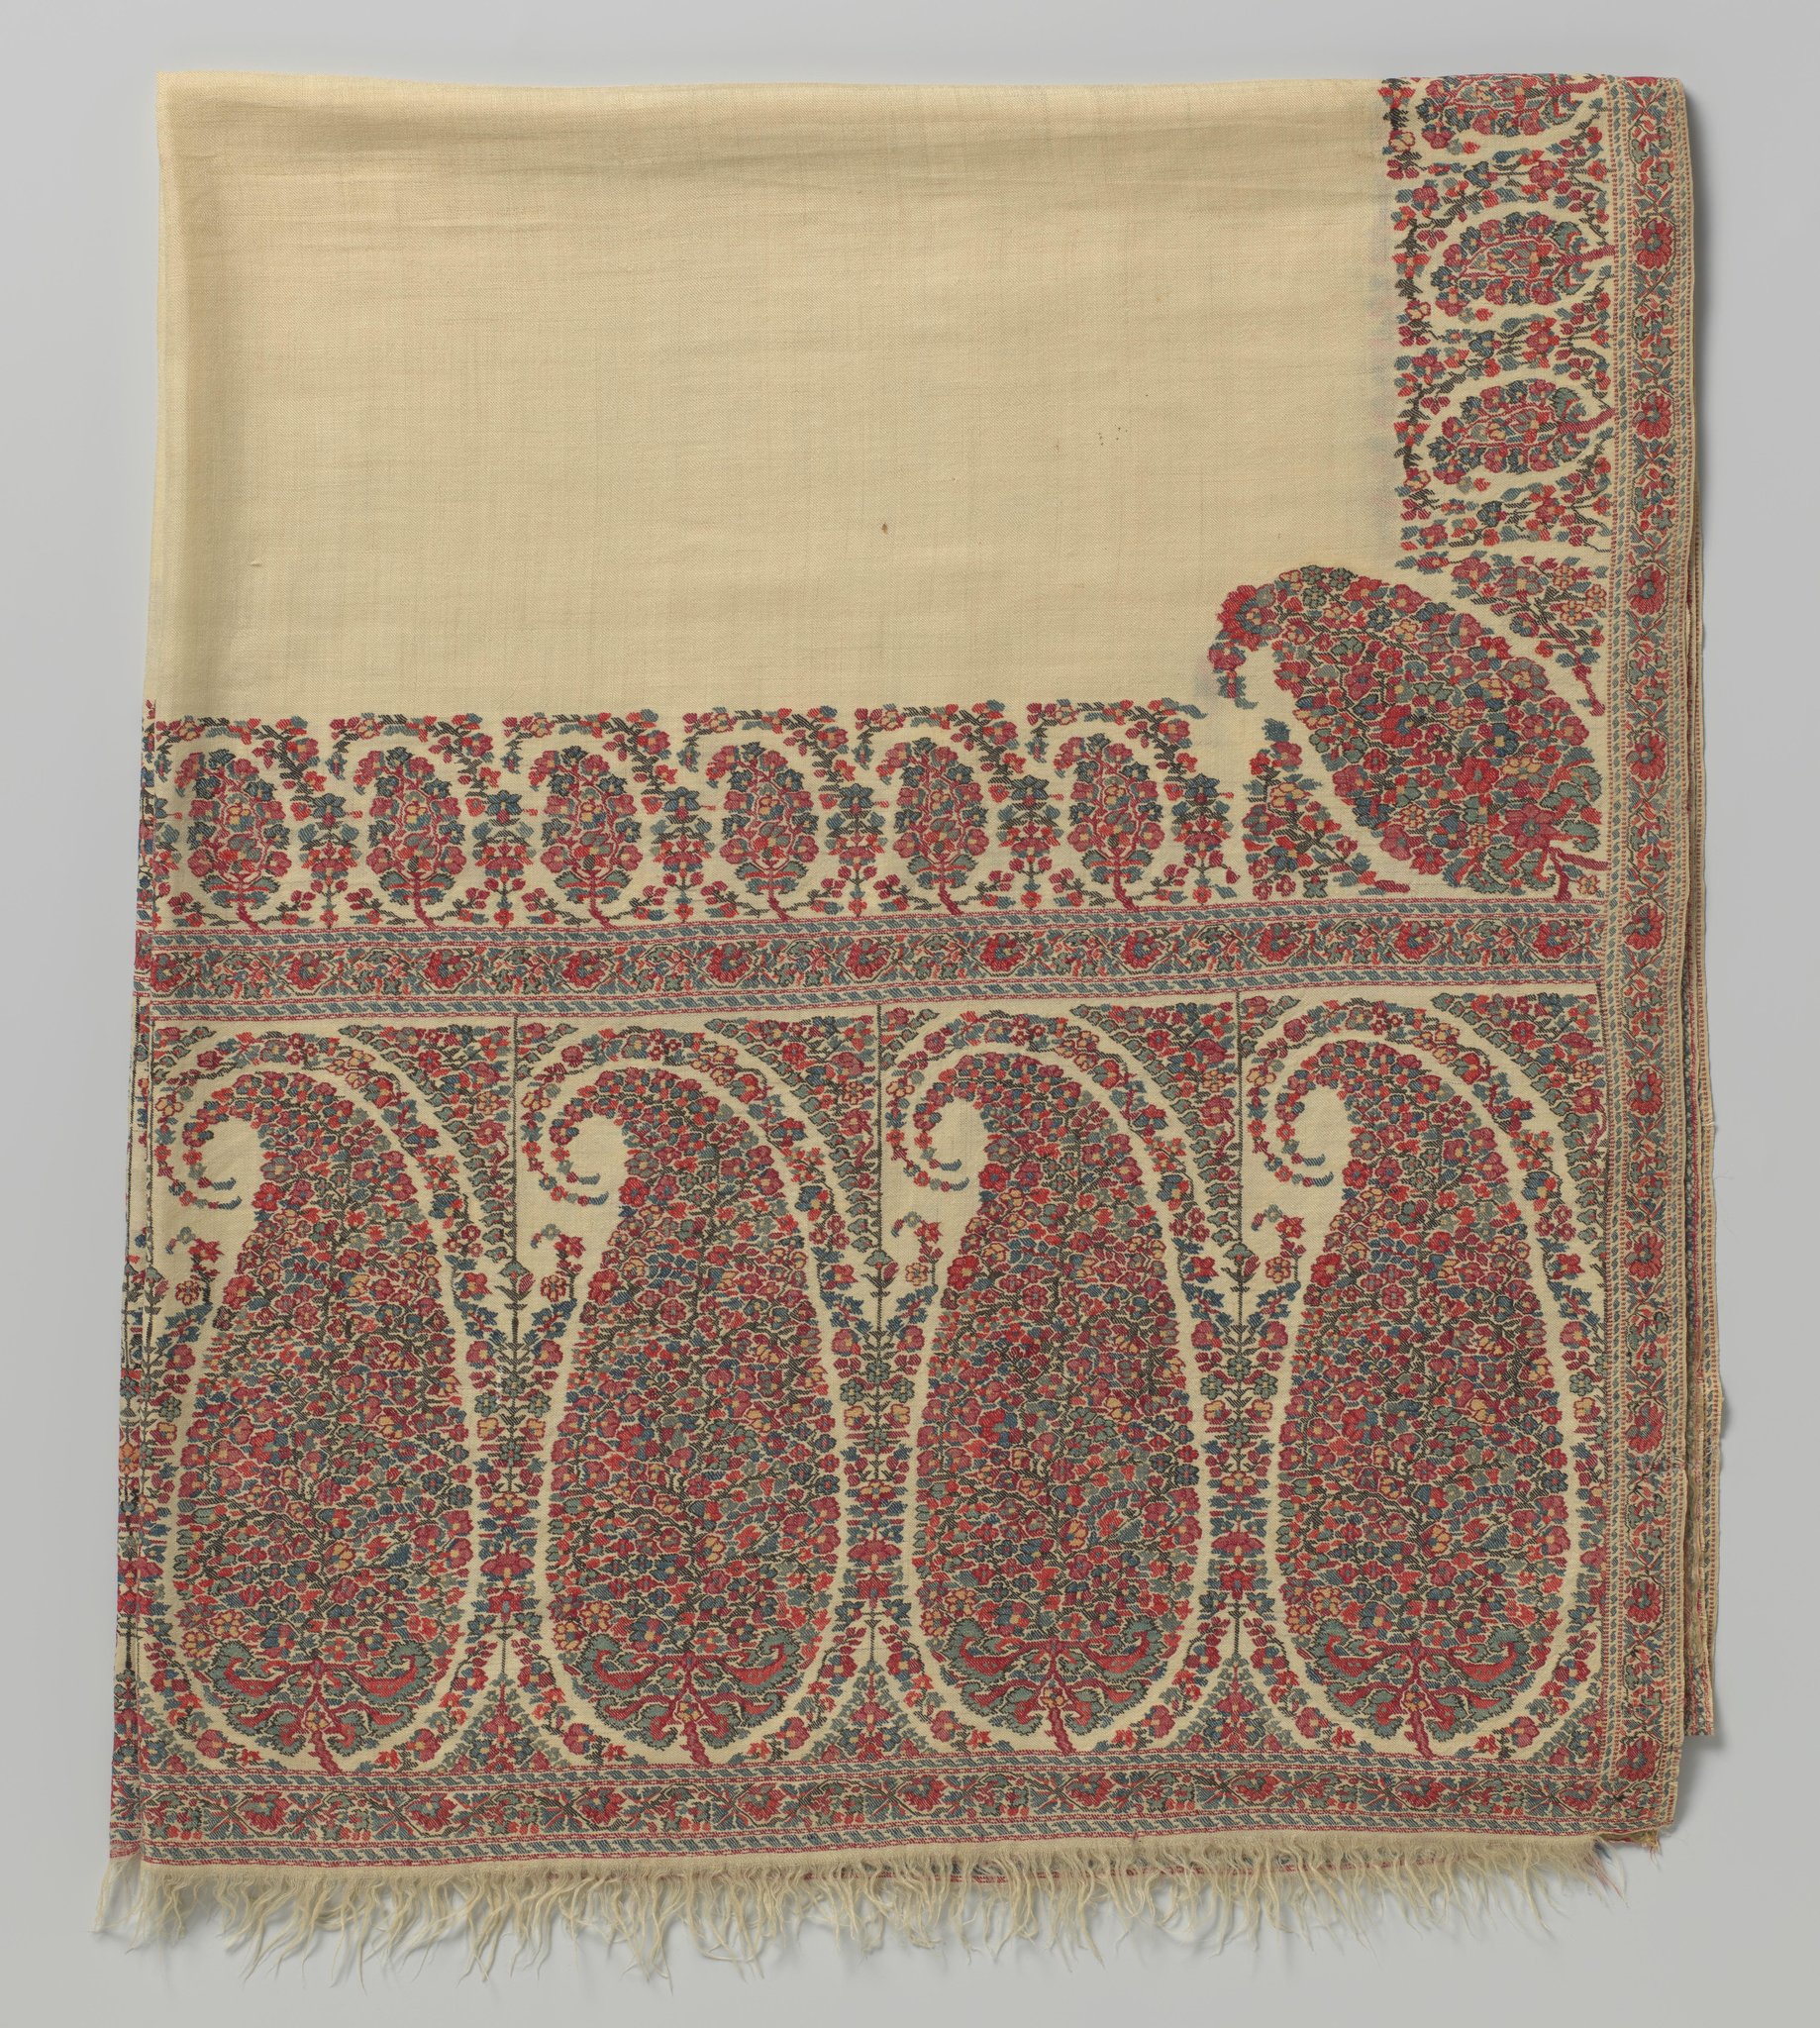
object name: scarf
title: Shawl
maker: Anonymous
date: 1800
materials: wool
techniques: brocade, weave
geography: kashmir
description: Weaving cashmere shawls was a labour-intensive process. To make a shawl of this width, about 3000 warp threads were attached to a loom. For finer shawls, this could run up to 4800 threads. The weaver moved the weft thread with a wooden shuttle alternately over two warp threads, then under two others. This yielded a shawl that was supple, lightweight and almost silky to the touch.